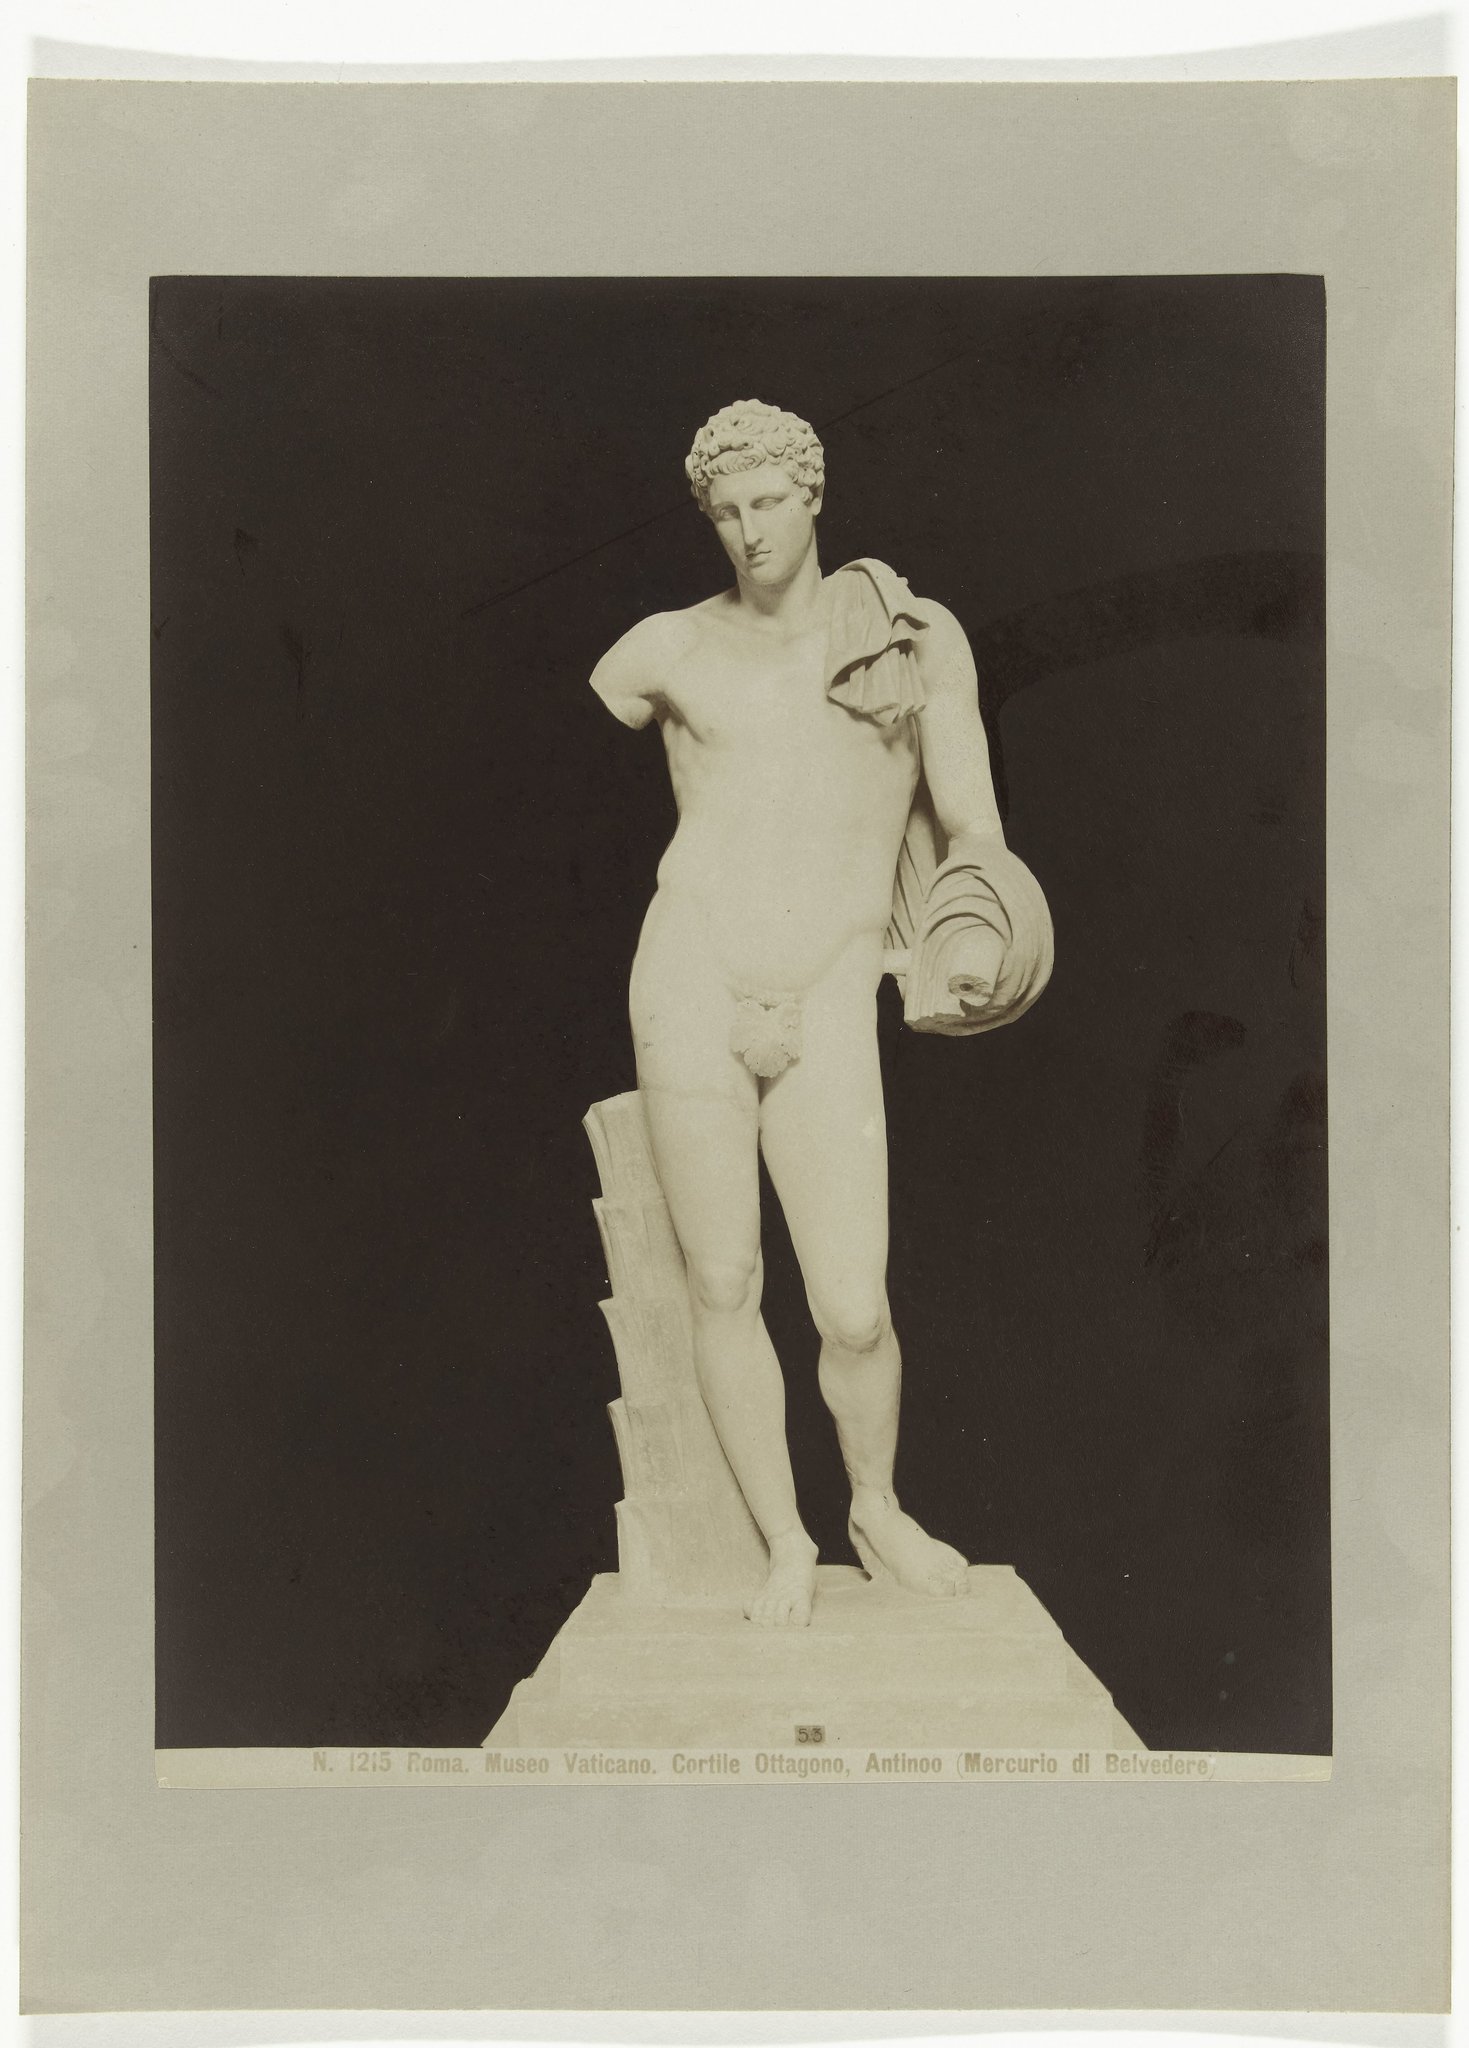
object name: photograph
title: Sculptuur van Antinous van de Belvedere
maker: Anonymous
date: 1880-1904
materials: cardboard, paper, photographic support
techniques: albumen print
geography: rome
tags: vaticaanse musea